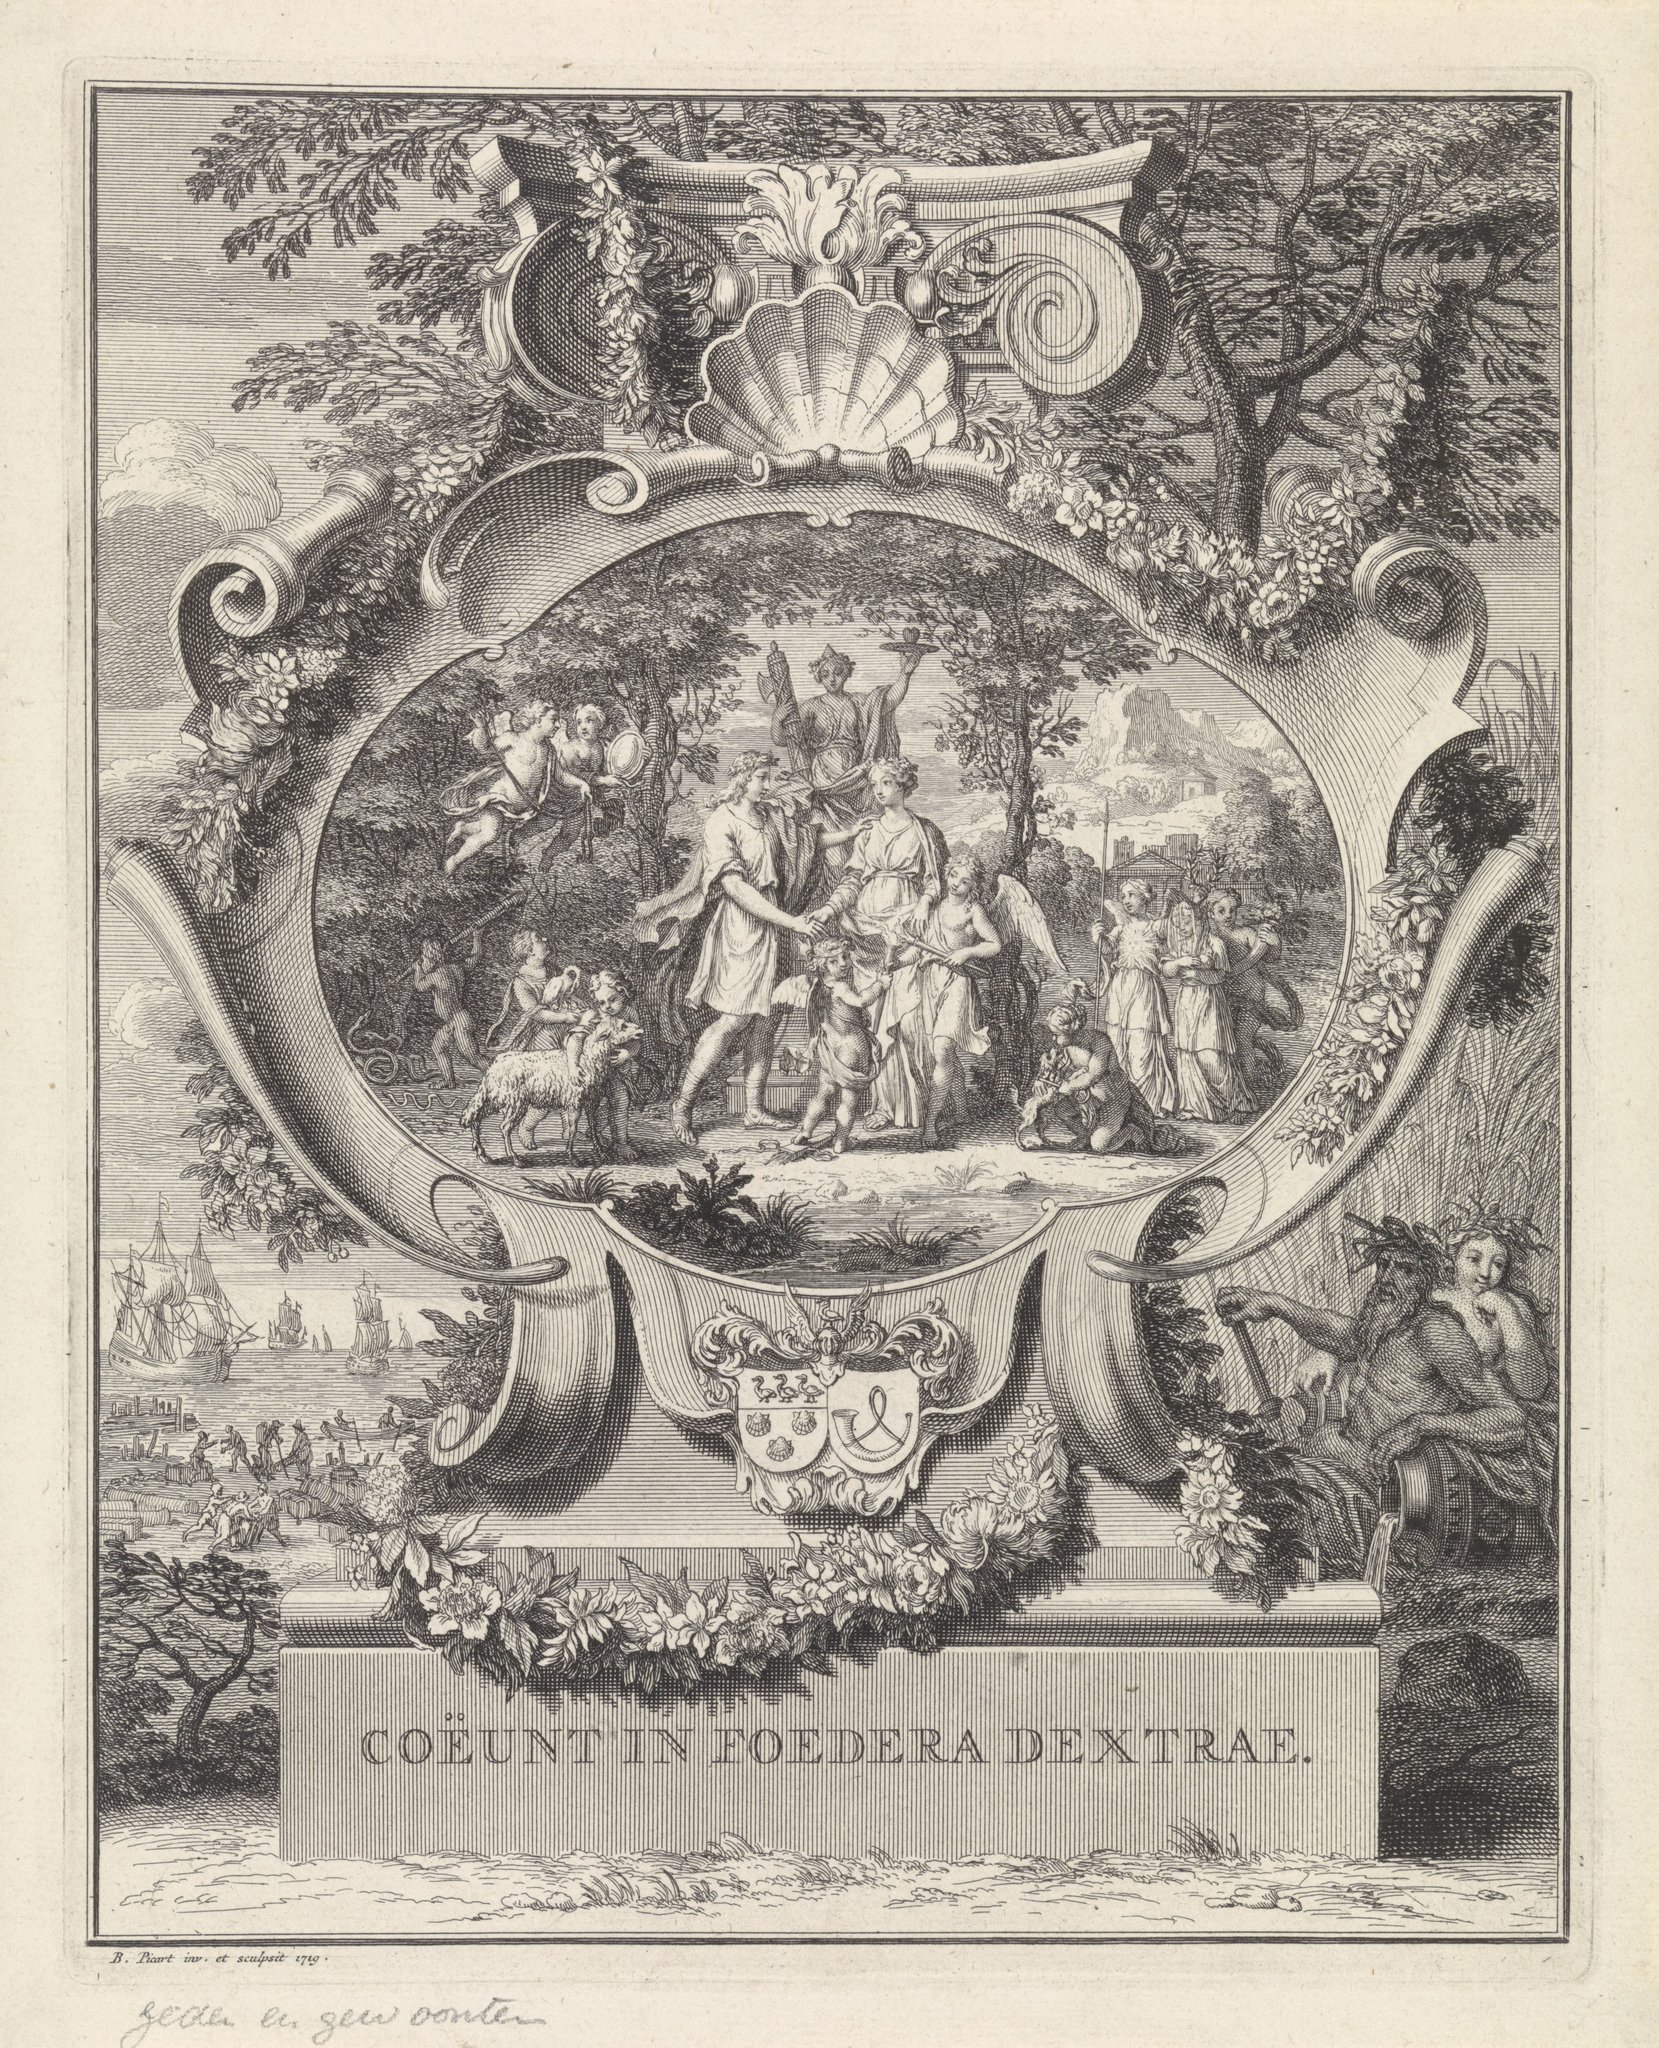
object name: print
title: Allegorische voorstelling ter gelegenheid van het huwelijk van Jacob Alewijn Ghijzen en Perina Vorsterman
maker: bernard picart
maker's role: draughtsman, print maker, publisher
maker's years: 1673-1733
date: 1719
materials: paper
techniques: engraving, etching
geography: amsterdam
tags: (story of) hymen(aeus), charity, 'caritas'; 'carità' (ripa) ~ one of the three theological virtues, chastity, faith, 'fides'; 'fede', 'fede catholica', 'fede christiana', 'fede christiana catholica' (ripa) ~ one of the three theological virtues, genii (roman tutelary spirits); 'genio' (ripa), marriage, married couple, 'matrimonium', disagreement, discord; 'discordia' (ripa), precaution, temperance, moderation; 'misura' (ripa)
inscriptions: collector's mark: Lugt 240, collector's mark: Lugt 2166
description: Allegorische voorstelling in een cartouche ter gelegenheid van een huwelijk. Het echtpaar houdt elkaars rechterhand vast, terwijl Hymen en Amor twee fakkels bij elkaar houden. Het paar wordt omgeven door personificaties van allerlei deugden zoals Geloof, Deugd, Kuisheid, Lieflijkheid, Liefde, Matigheid en Voorzichtigheid. Een putto jaagt op de tweedracht in de vorm van twee slangen. Midden onder op het basement het devies: Coëunt in Foedera Dextrae. Links schepen op zee en rechts de stroomgoden van Amstel en IJ. Prent ter gelegenheid van het huwelijk van Jacob Alewijn Ghijzen en Perina Vorsterman in 1719 te Amsterdam.